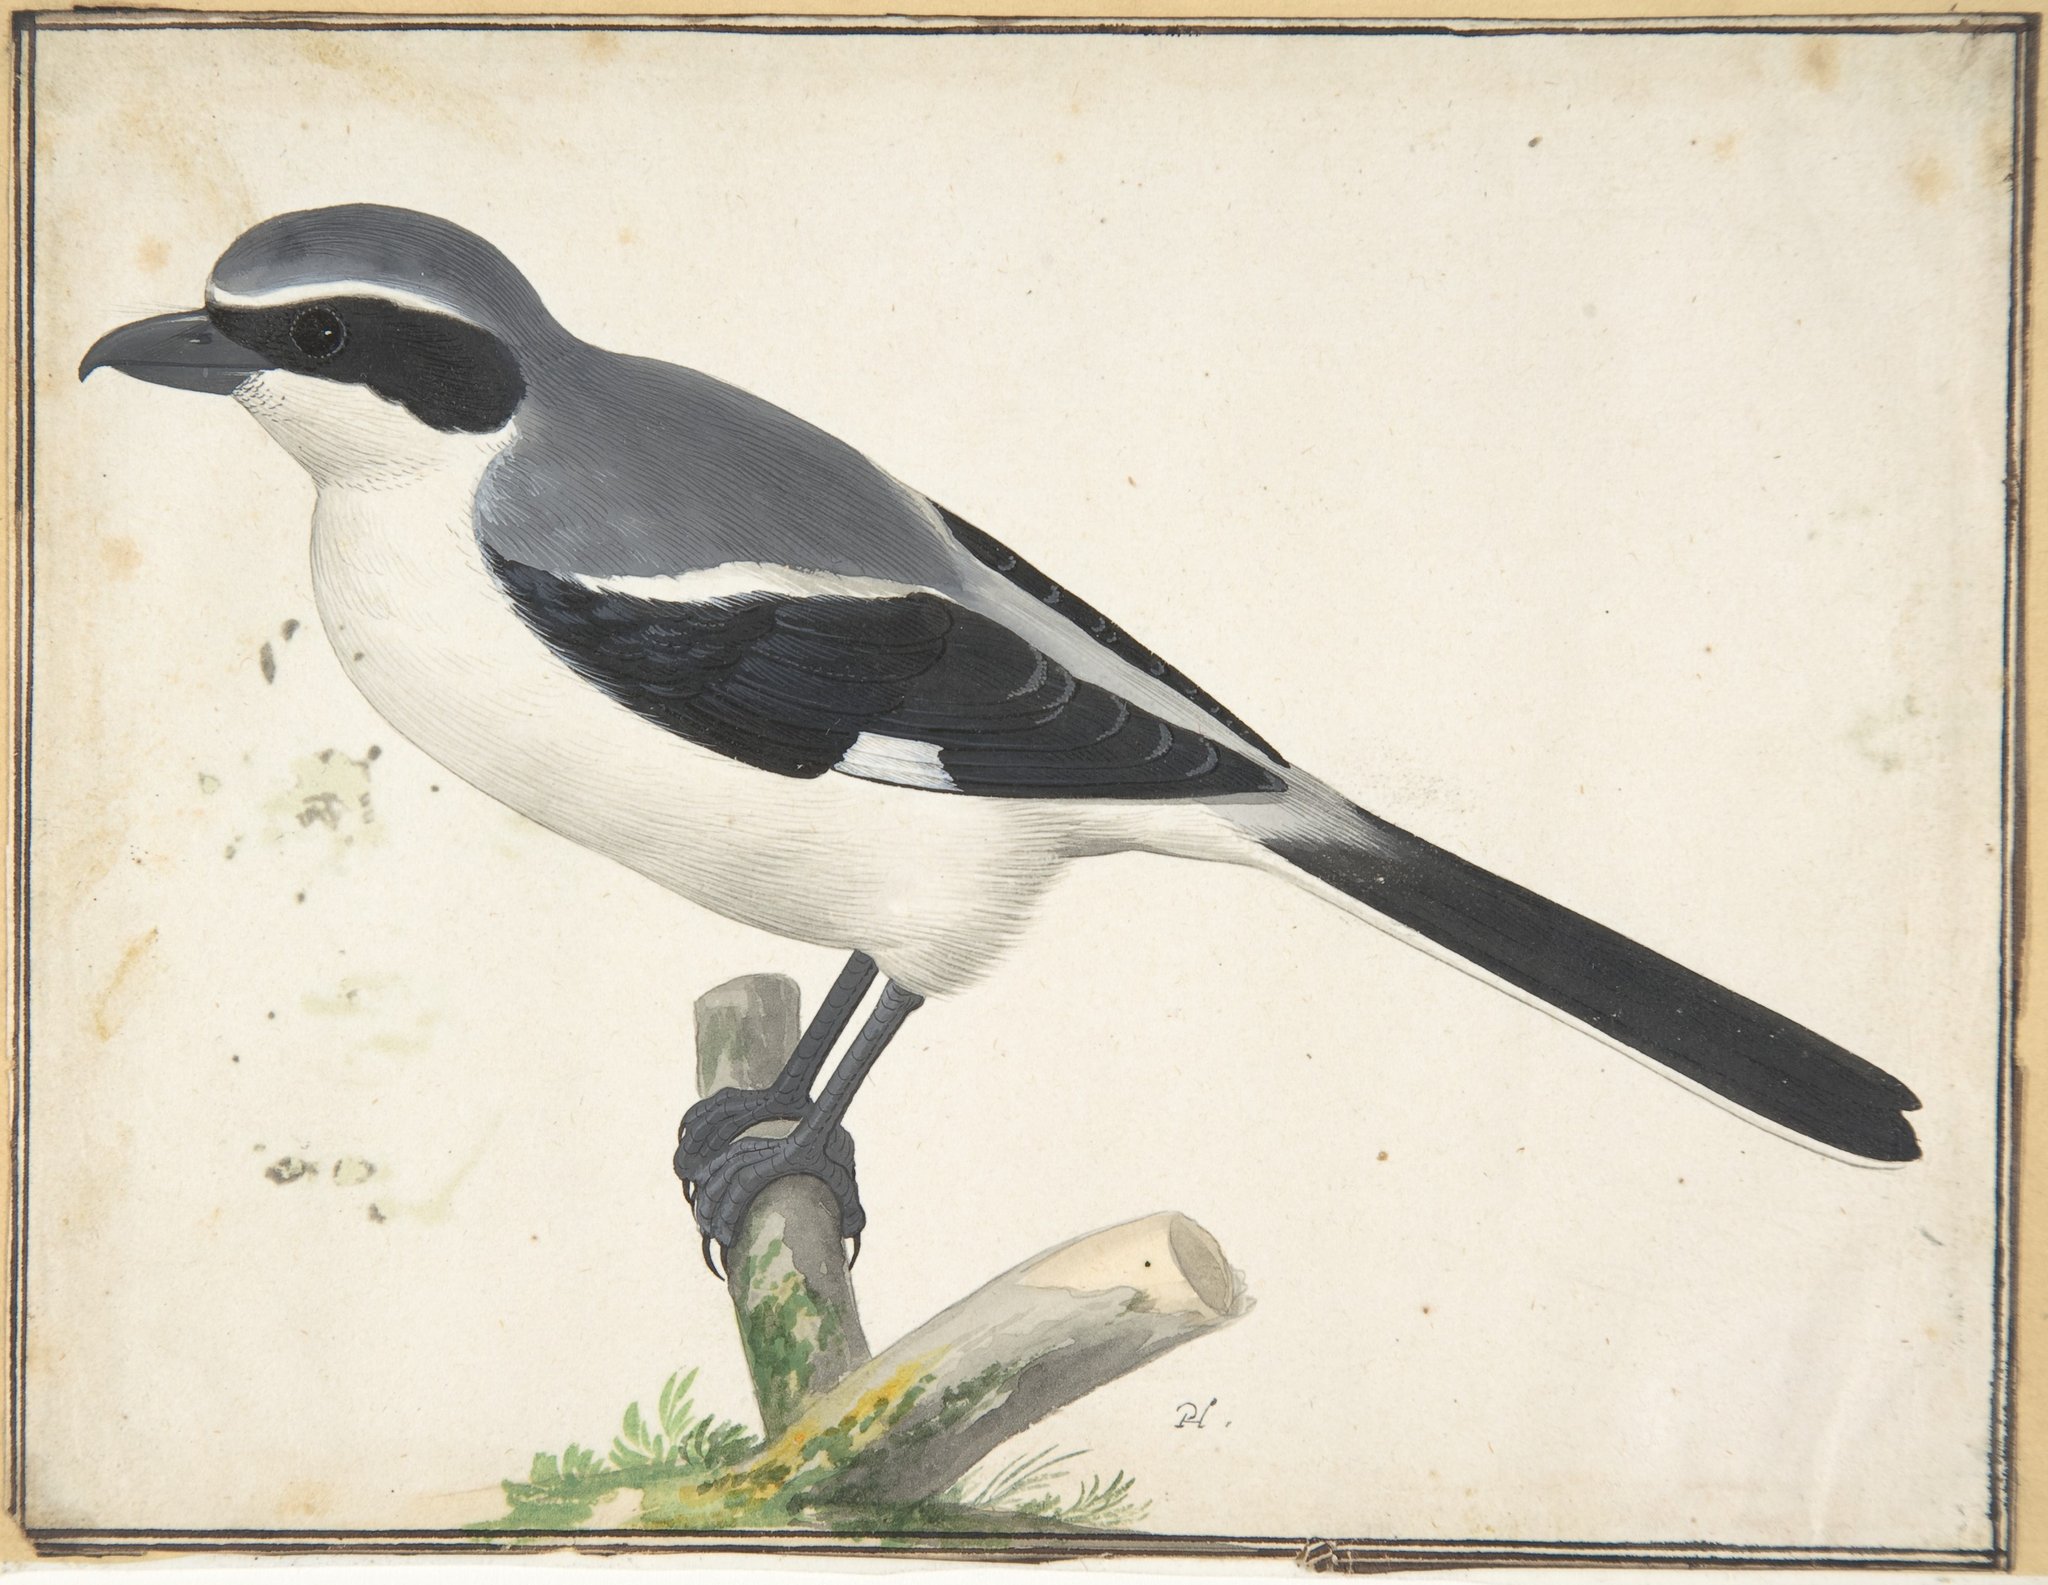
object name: drawing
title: A Great Grey Shrike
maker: pieter holsteyn (ii)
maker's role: artist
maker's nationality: dutch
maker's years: 1614-1673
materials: paint, watercolor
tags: birds